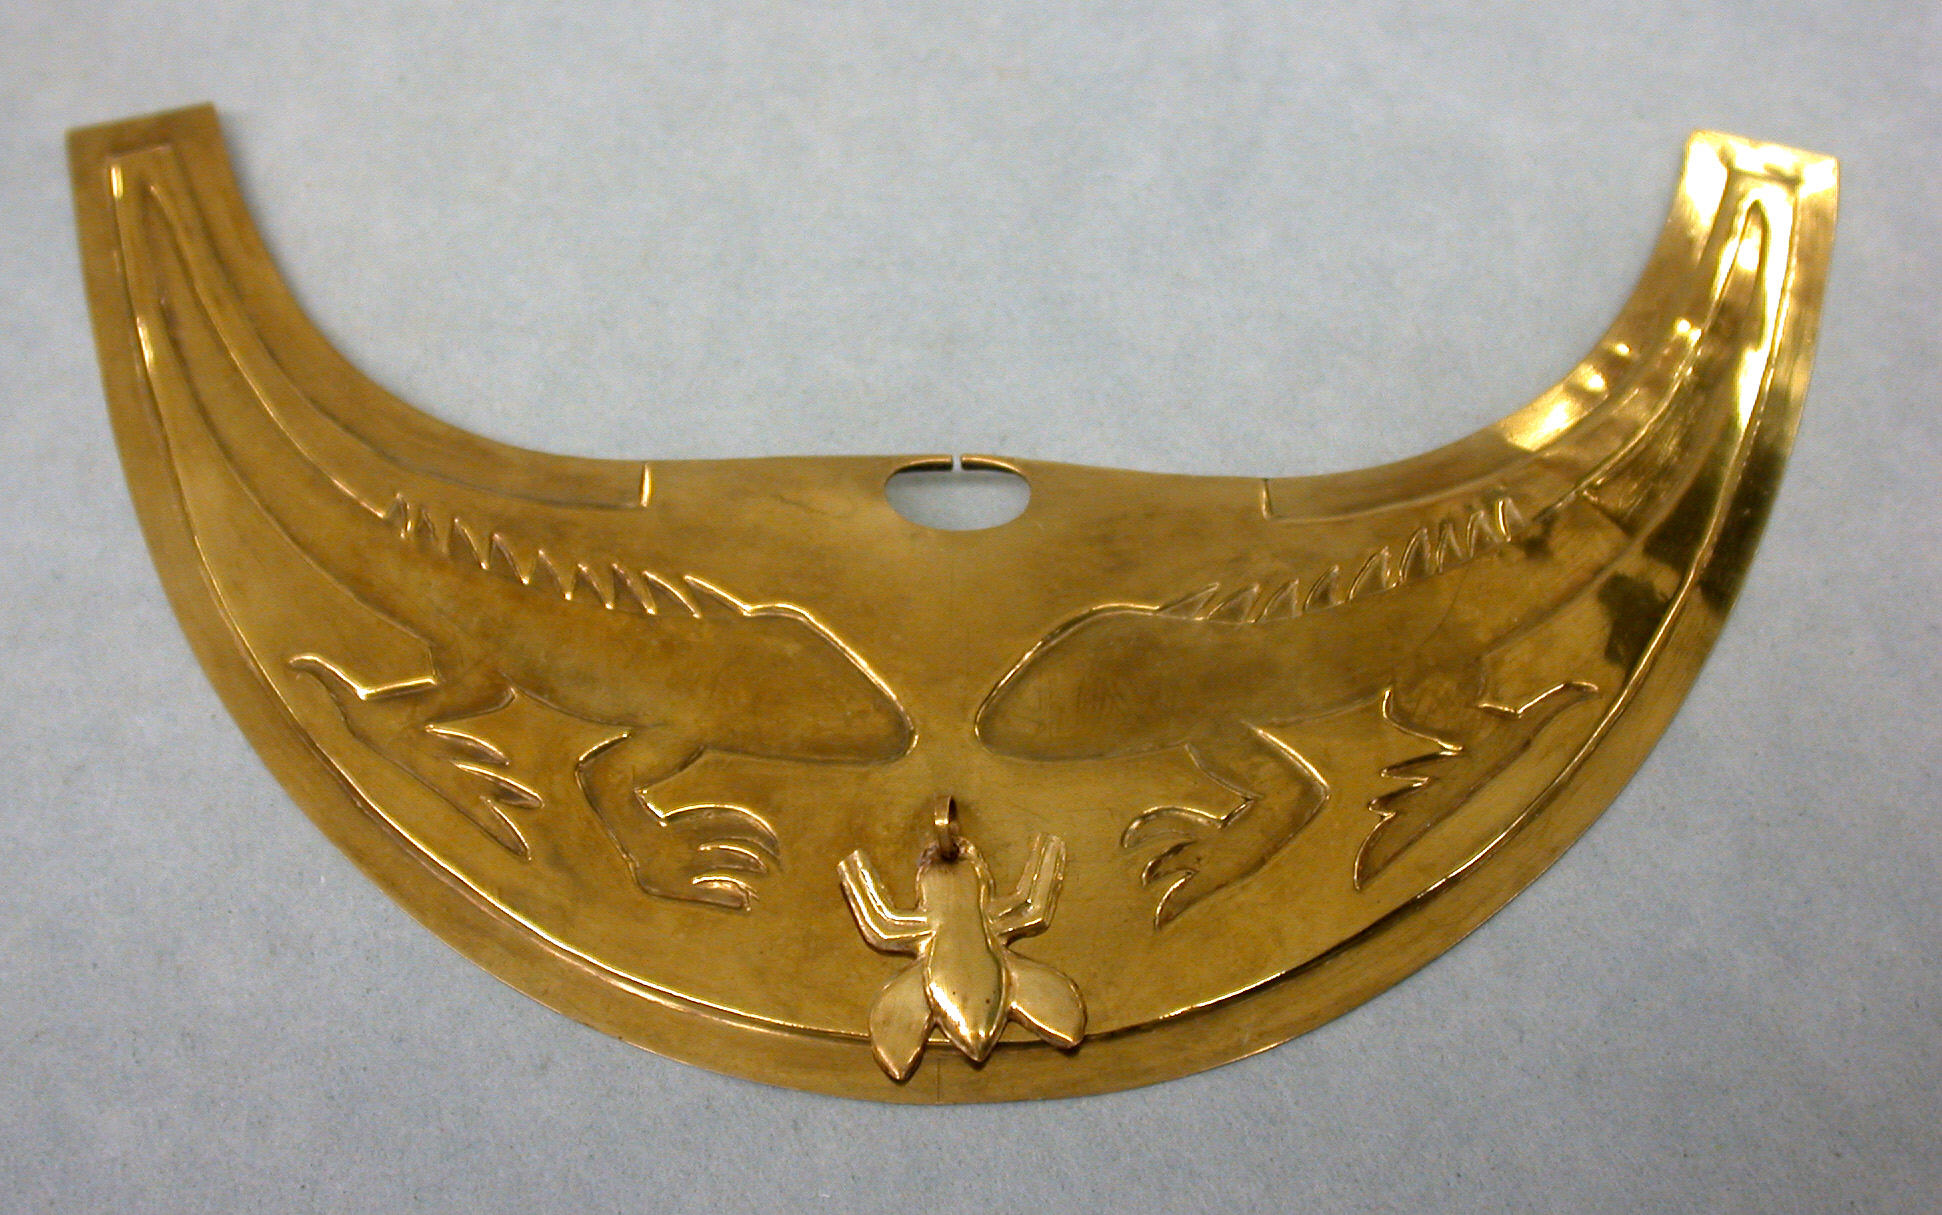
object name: nose ornament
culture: moche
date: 501-700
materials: gold, stone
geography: peru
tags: animals,insects